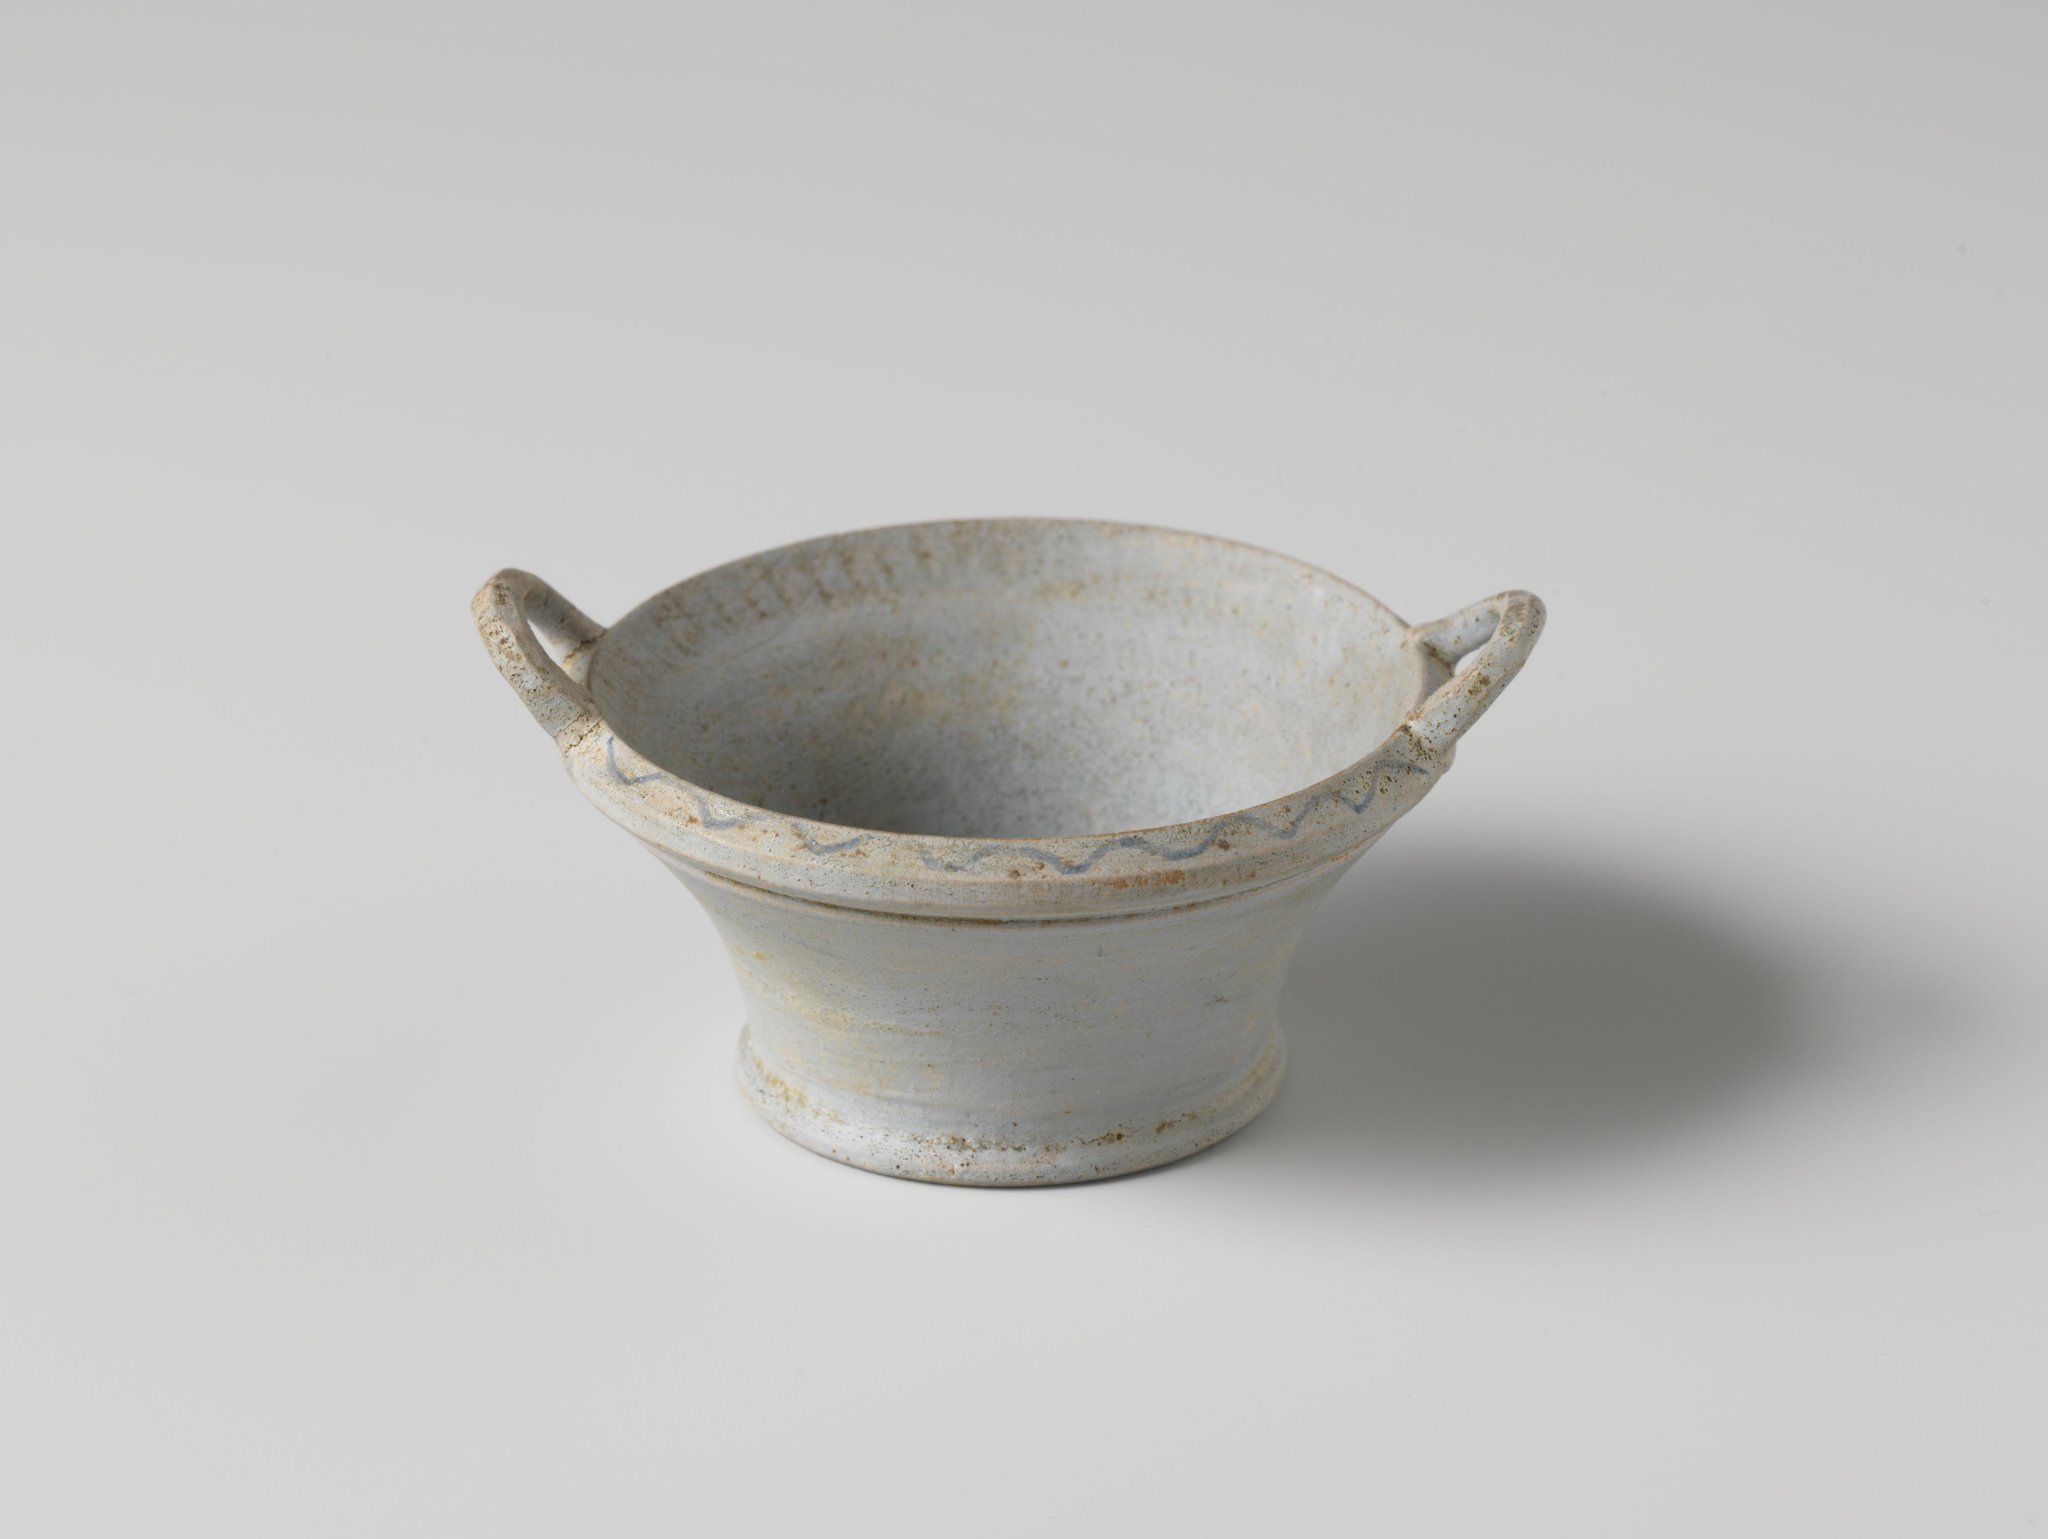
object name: teil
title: Teil met twee handgrepen, versierd met blauwe golflijn op grijs fond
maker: Anonymous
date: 1700-1799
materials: wood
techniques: painted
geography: amsterdam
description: Teil van lichtgrijs geschilderd hout versierd met blauw golflijn op de rand; twee handgrepen.